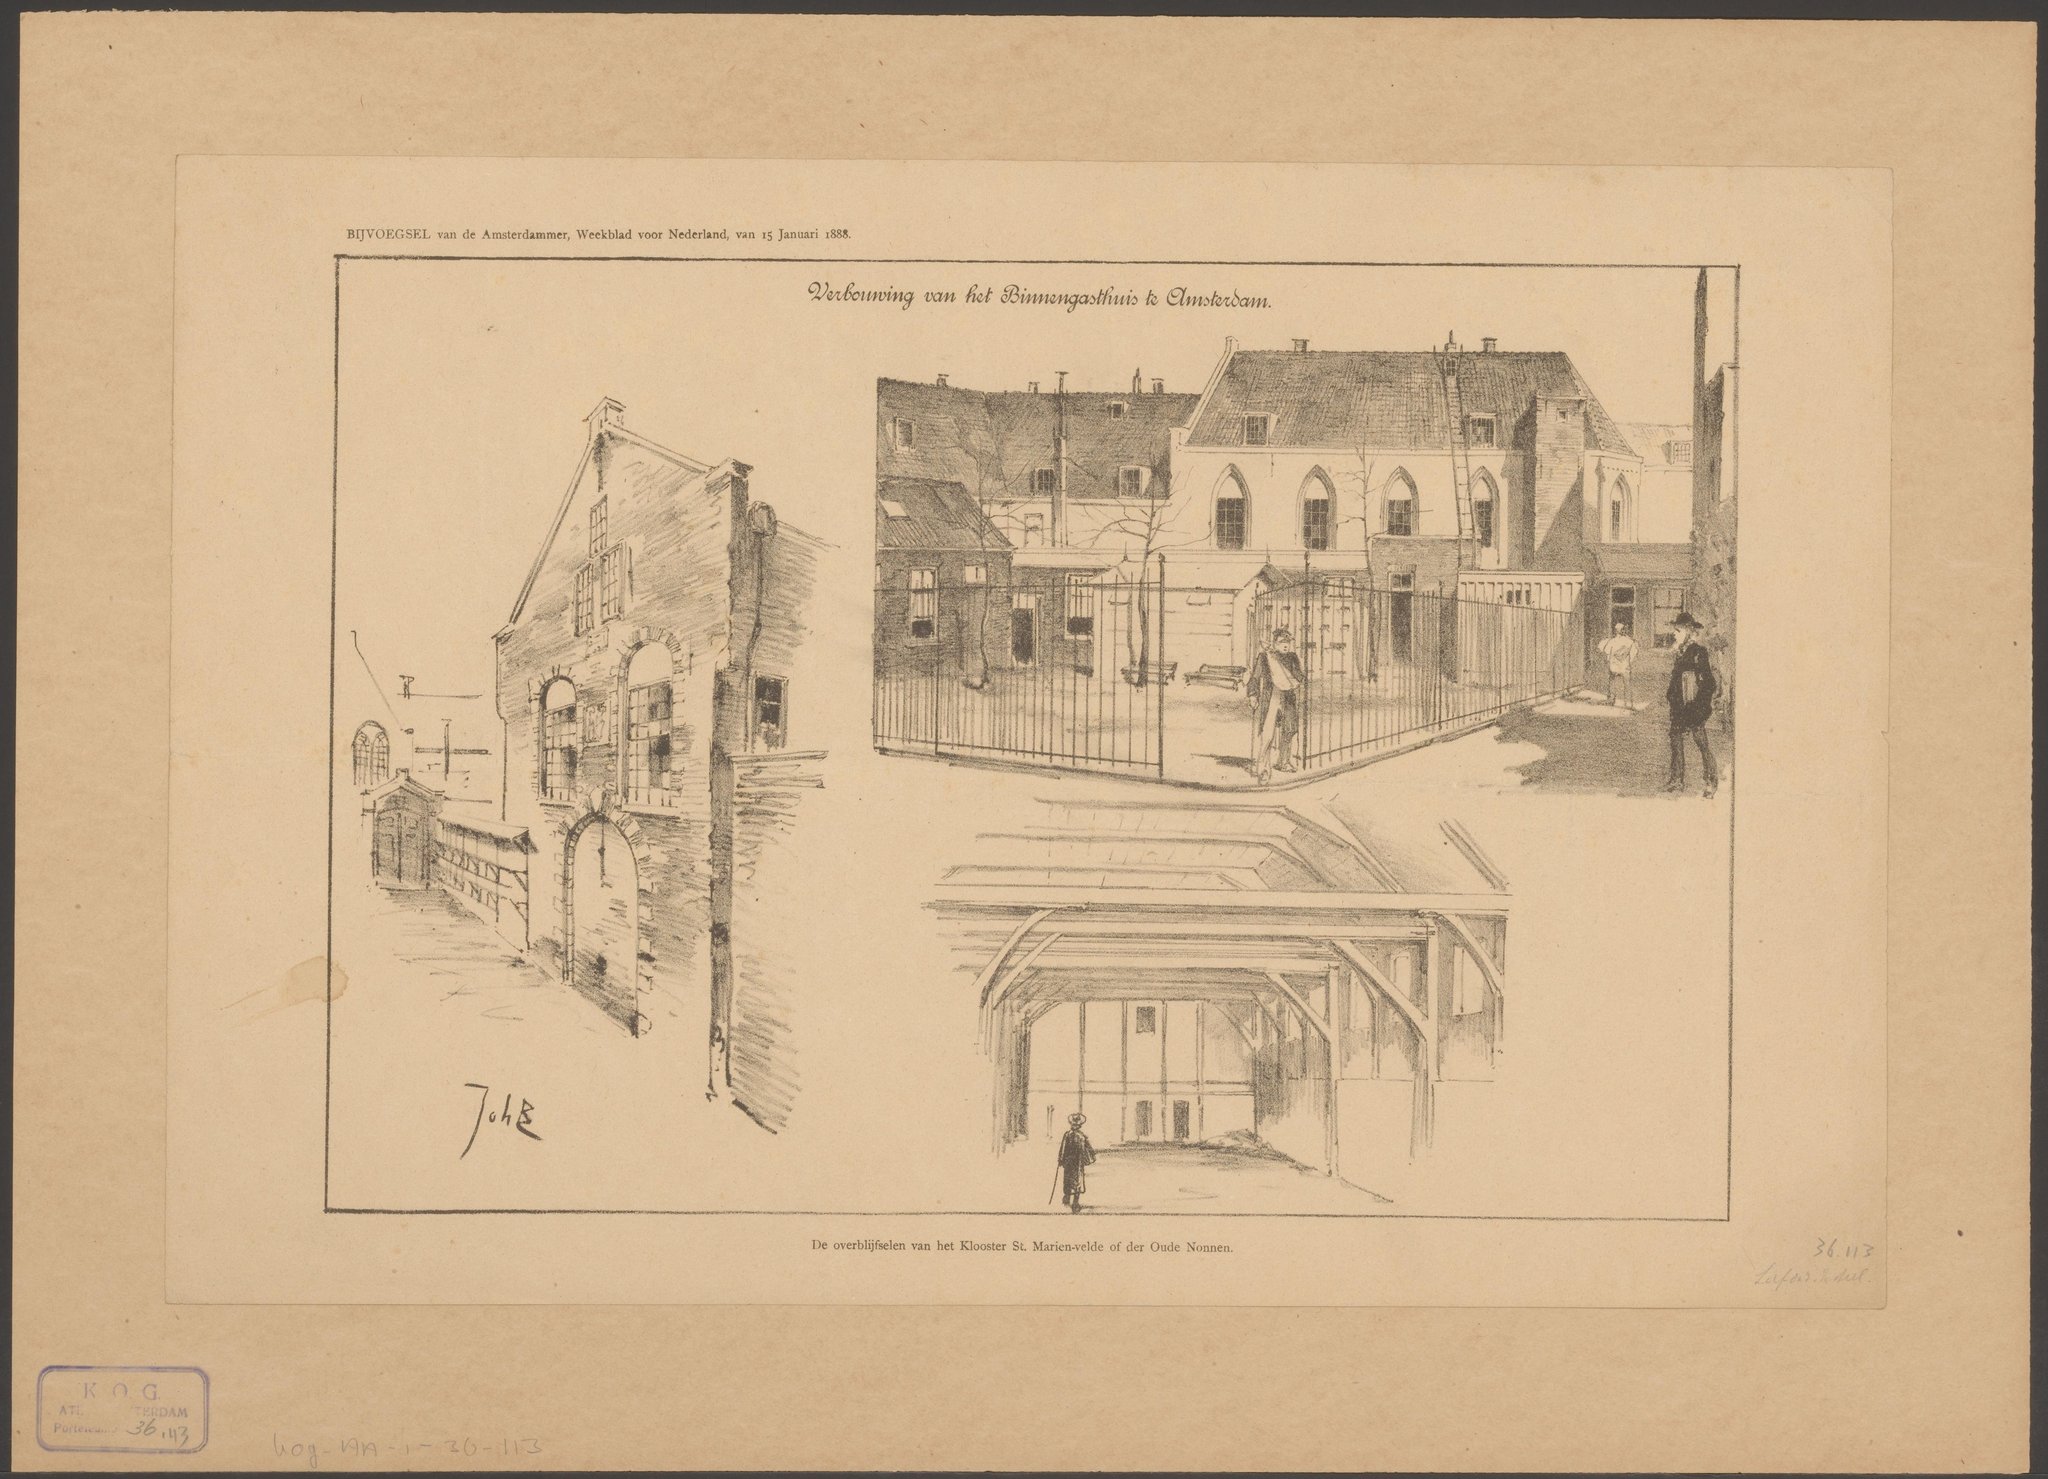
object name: print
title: Gezicht op het Binnengasthuis te Amsterdam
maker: johan braakensiek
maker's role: draughtsman, print maker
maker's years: 1858-1940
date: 1888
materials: paper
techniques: lithograph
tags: hospital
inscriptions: collector's mark: Lugt 1641b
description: Drie voorstellingen met de overblijfselen van het Sint Marien-velde. Onderwerpsrubriek binnen de Atlas Amsterdam: Armwezen en liefdadige instellingen: I. Stadsinrichtingen: Binnengasthuis.